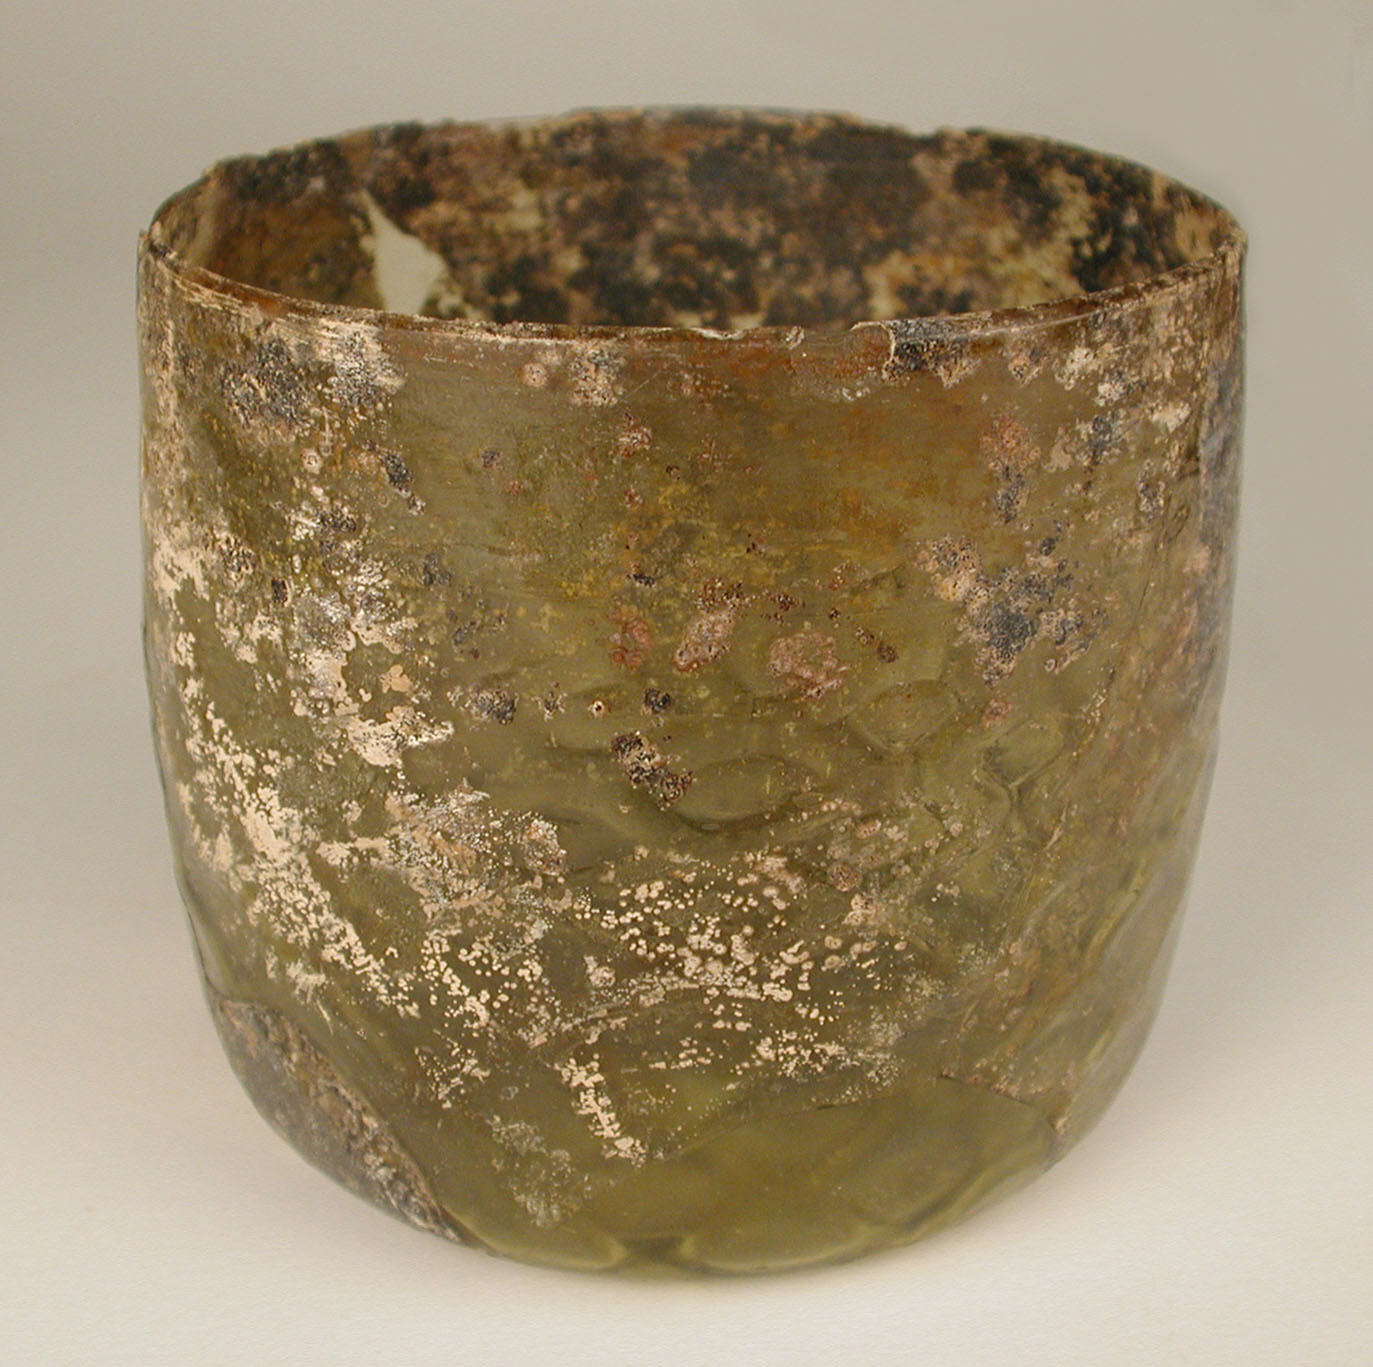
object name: beaker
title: Glass Beaker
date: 801-900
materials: glass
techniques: glassblowing, molding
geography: iran